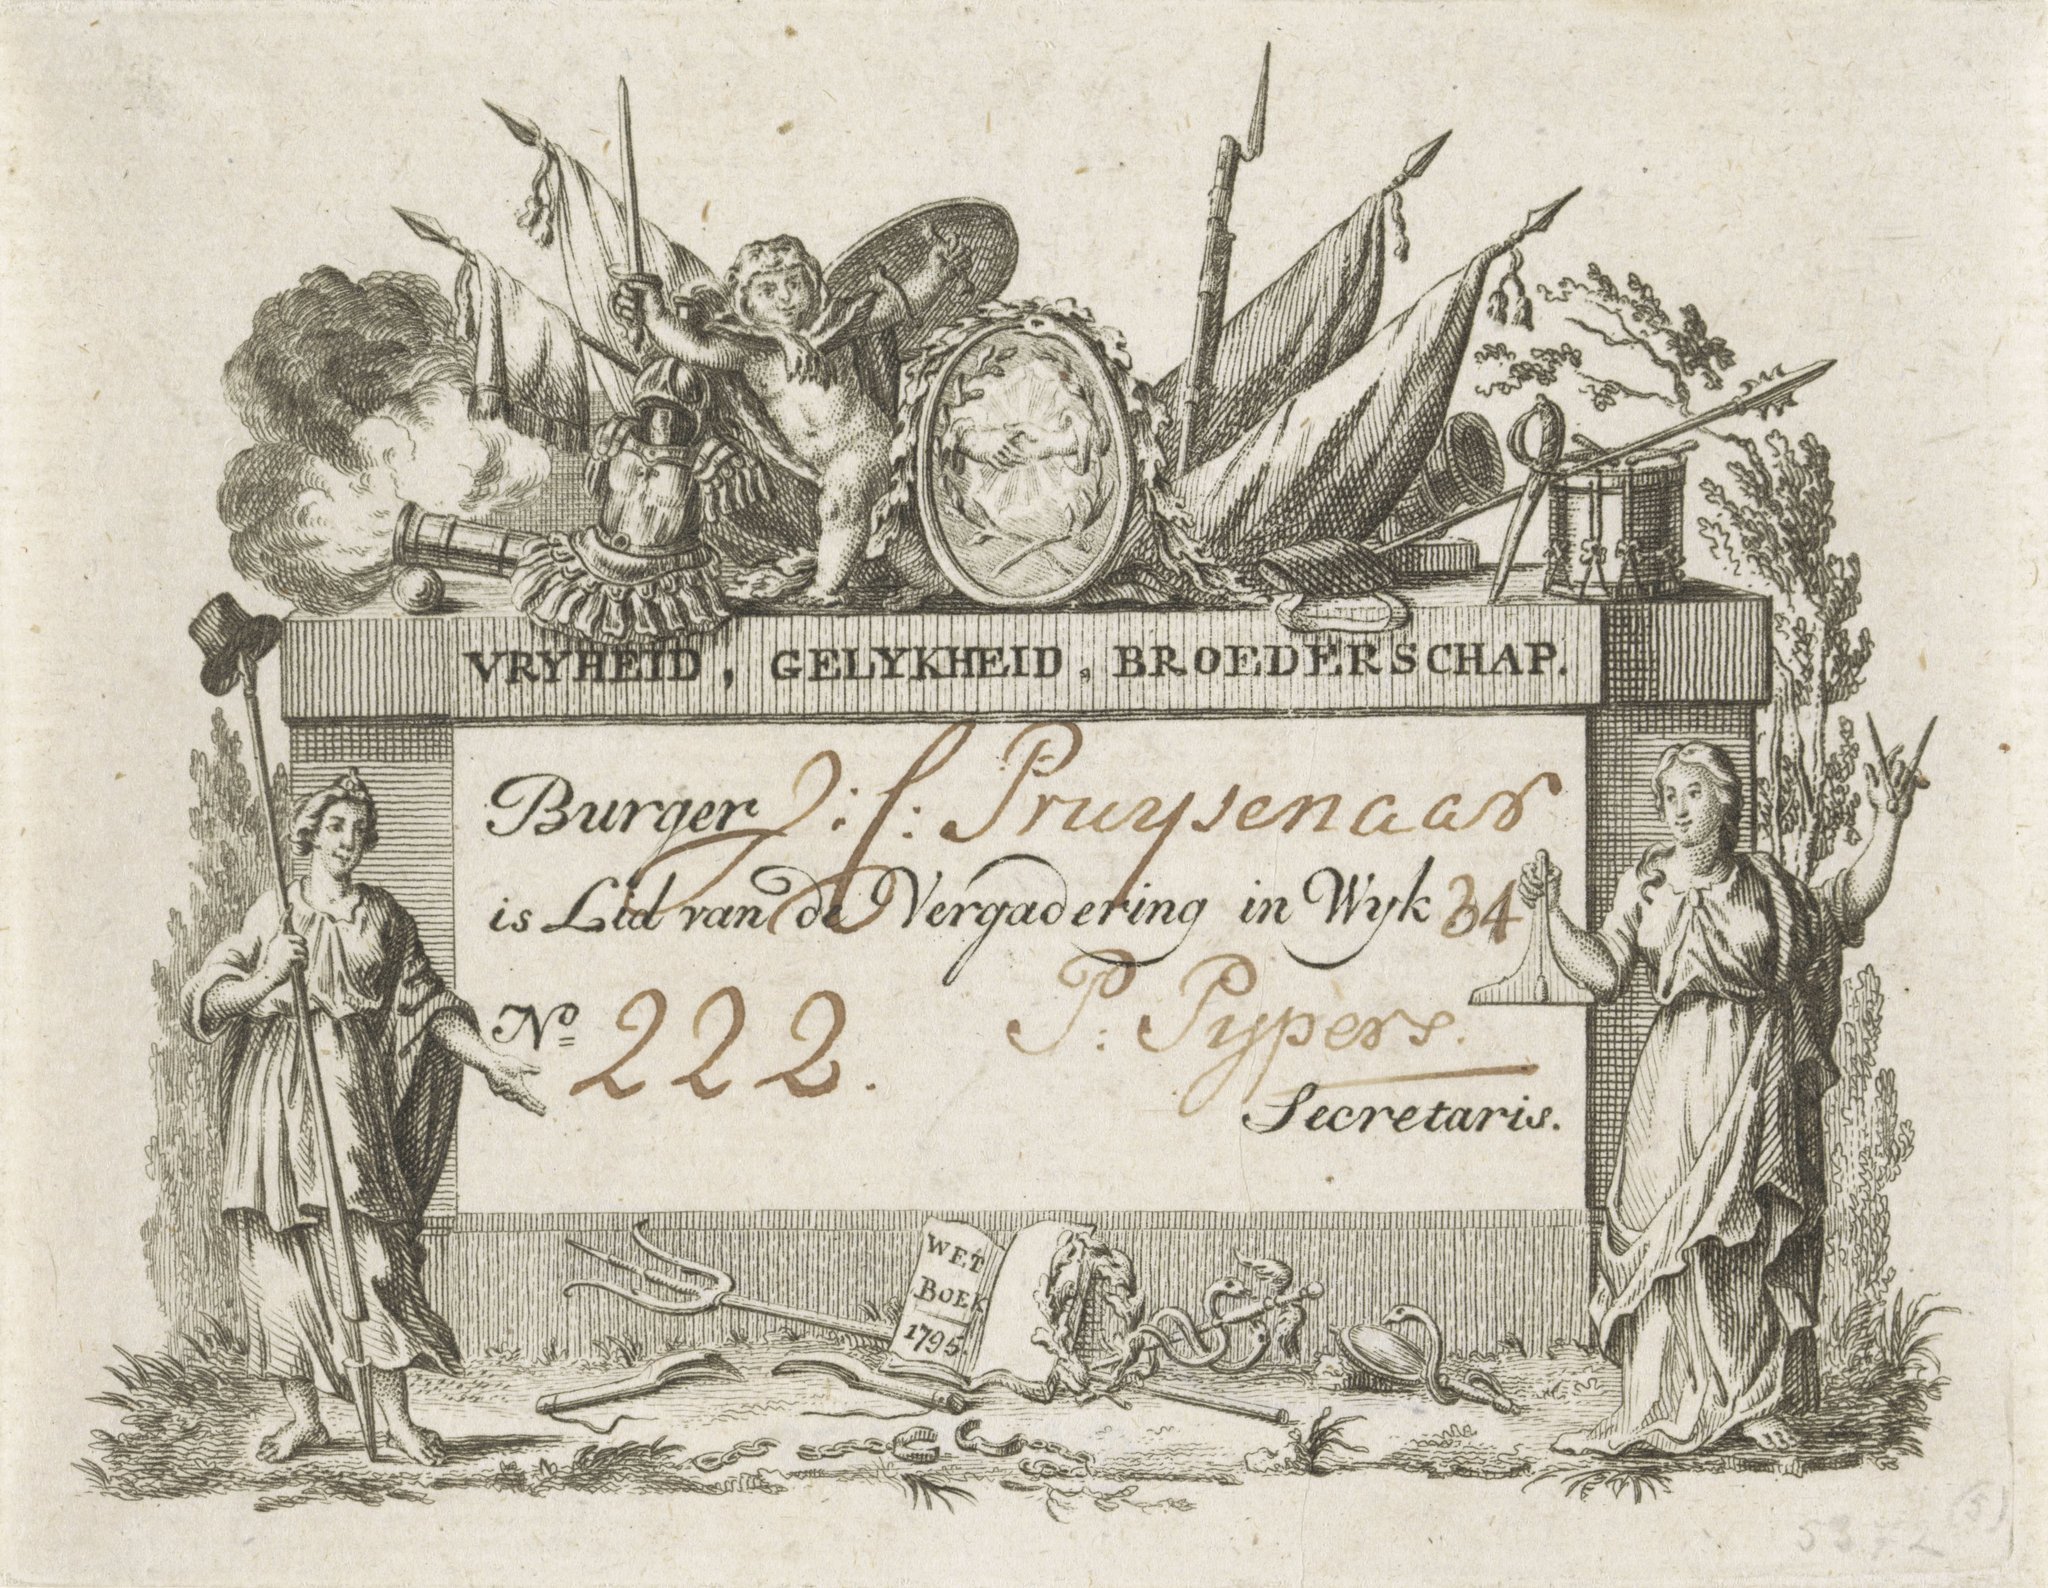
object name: membership certificate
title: Lidmaatschapsbewijs van wijkvergadering, 1795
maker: Anonymous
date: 1795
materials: paper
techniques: engraving, etching, pen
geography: netherlands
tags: equality, equity, fairness, righteousness; 'equalità', 'equità', 'giuditio giusto', 'ordine dritto e giusto', 'ugualità' (ripa) (+ abstract concept represented by female figure), freedom, liberty; 'libertà' (ripa) (+ abstract concept represented by female figure)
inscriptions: collector's mark: Lugt 2228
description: Voorgedrukt lidmaatschapsbewijs van de vergadering van de schutterij van wijk 34, te Amsterdam (?) 1795. Stenen voetstuk ingevuld met de naam van de burger J.C. Pruysenaar. Aan weerszijden de Vrijheid en de Gelijkheid, bovenop wapens.